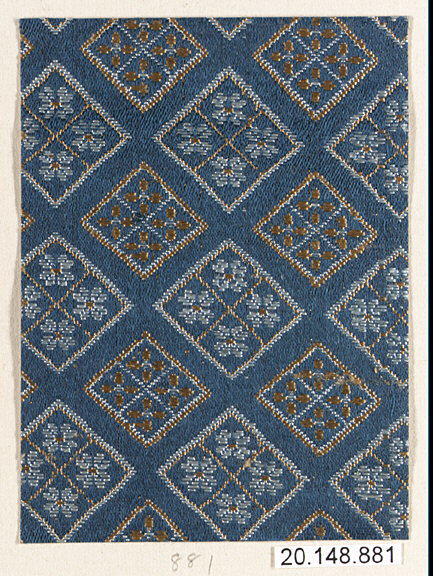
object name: piece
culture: japanese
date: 1701-1800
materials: silk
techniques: compound weave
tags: flowers